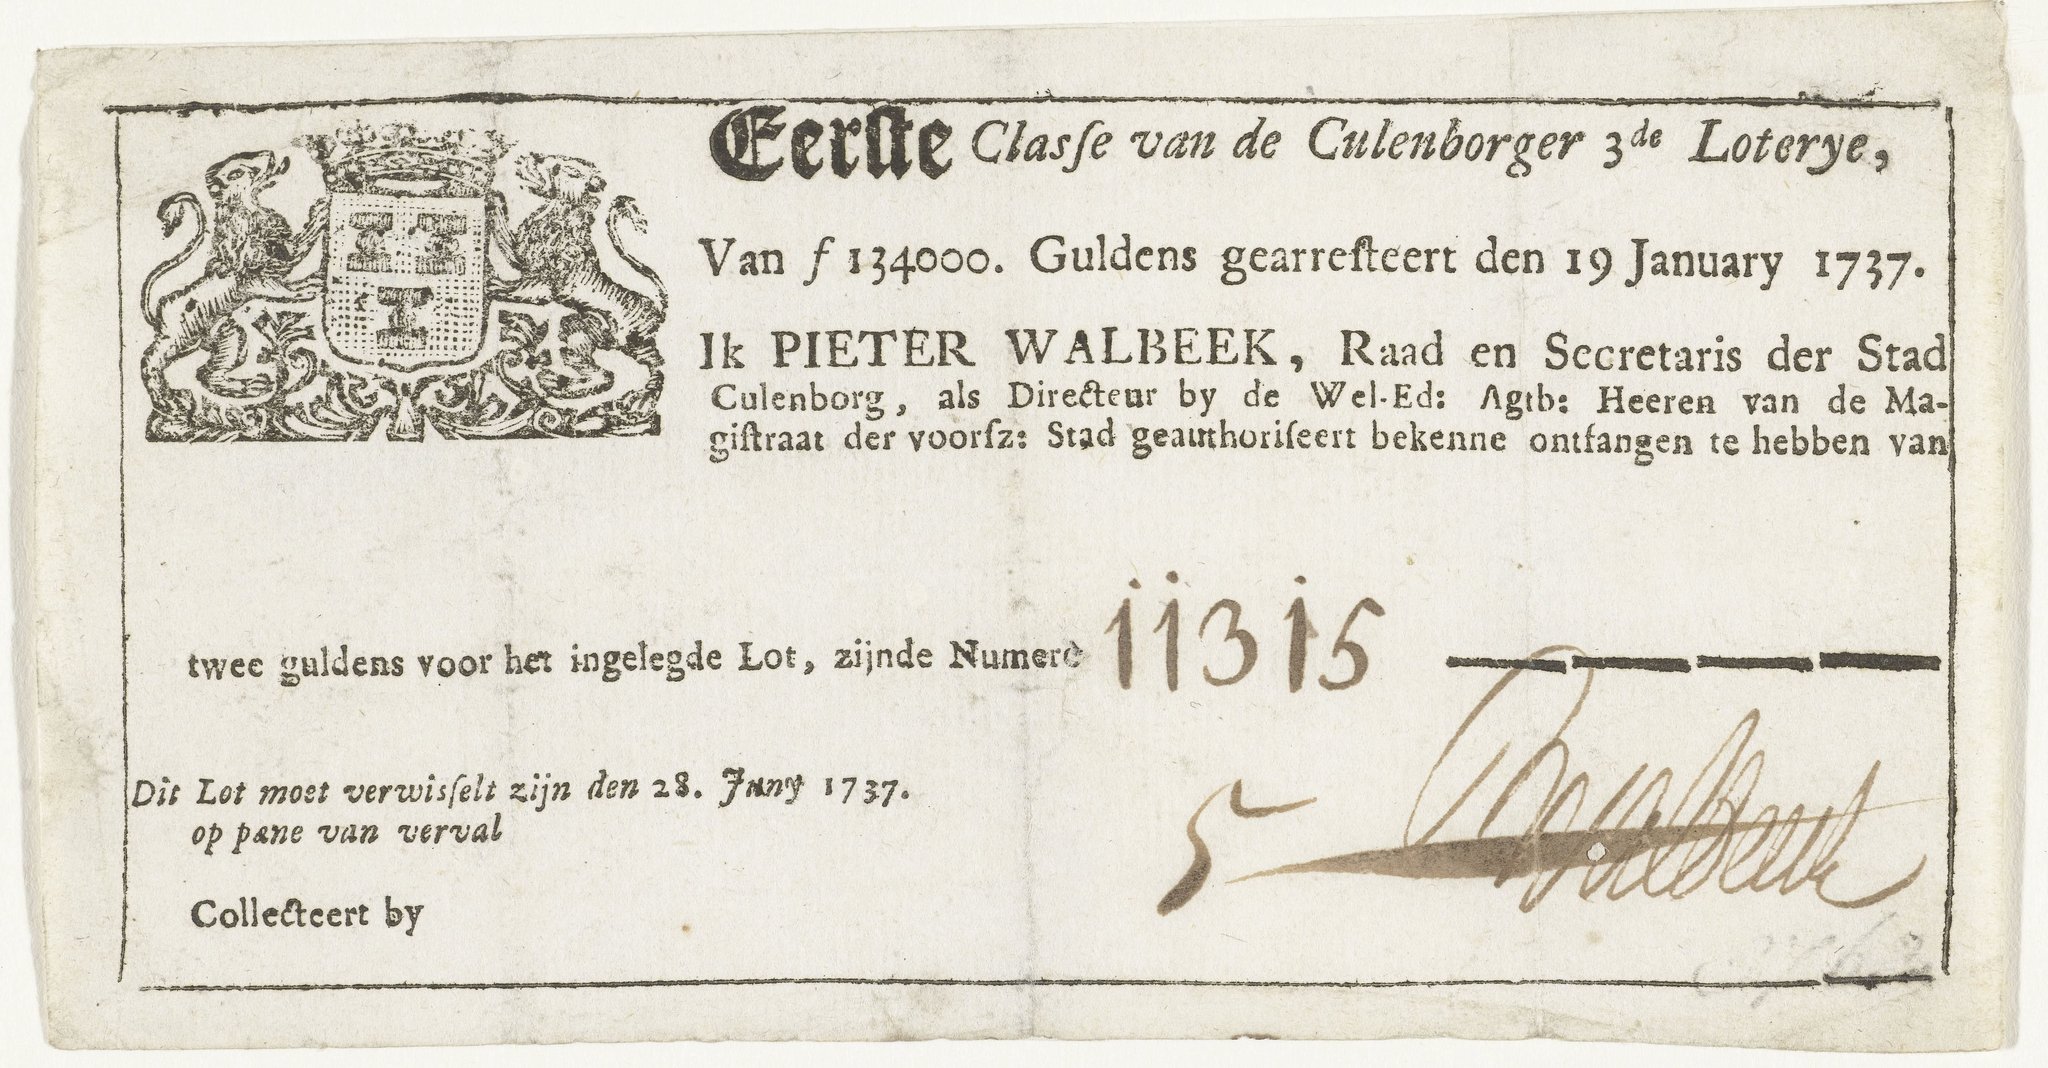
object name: loterijbrief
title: Loterijbriefje, 1737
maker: Anonymous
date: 1736-1737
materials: paper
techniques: letterpress printing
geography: northern netherlands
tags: raffle, lottery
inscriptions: collector's mark: Lugt 2228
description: Loterijbriefje van de Eerste Classe van de Culenborger 3de Loterye van f. 134000 gulden, 19 januari 1737. Het lotnummer met de pen ingevuld en getekend. Geauthoriseerd door de raad en secretaris van de stad Pieter Walbeek.